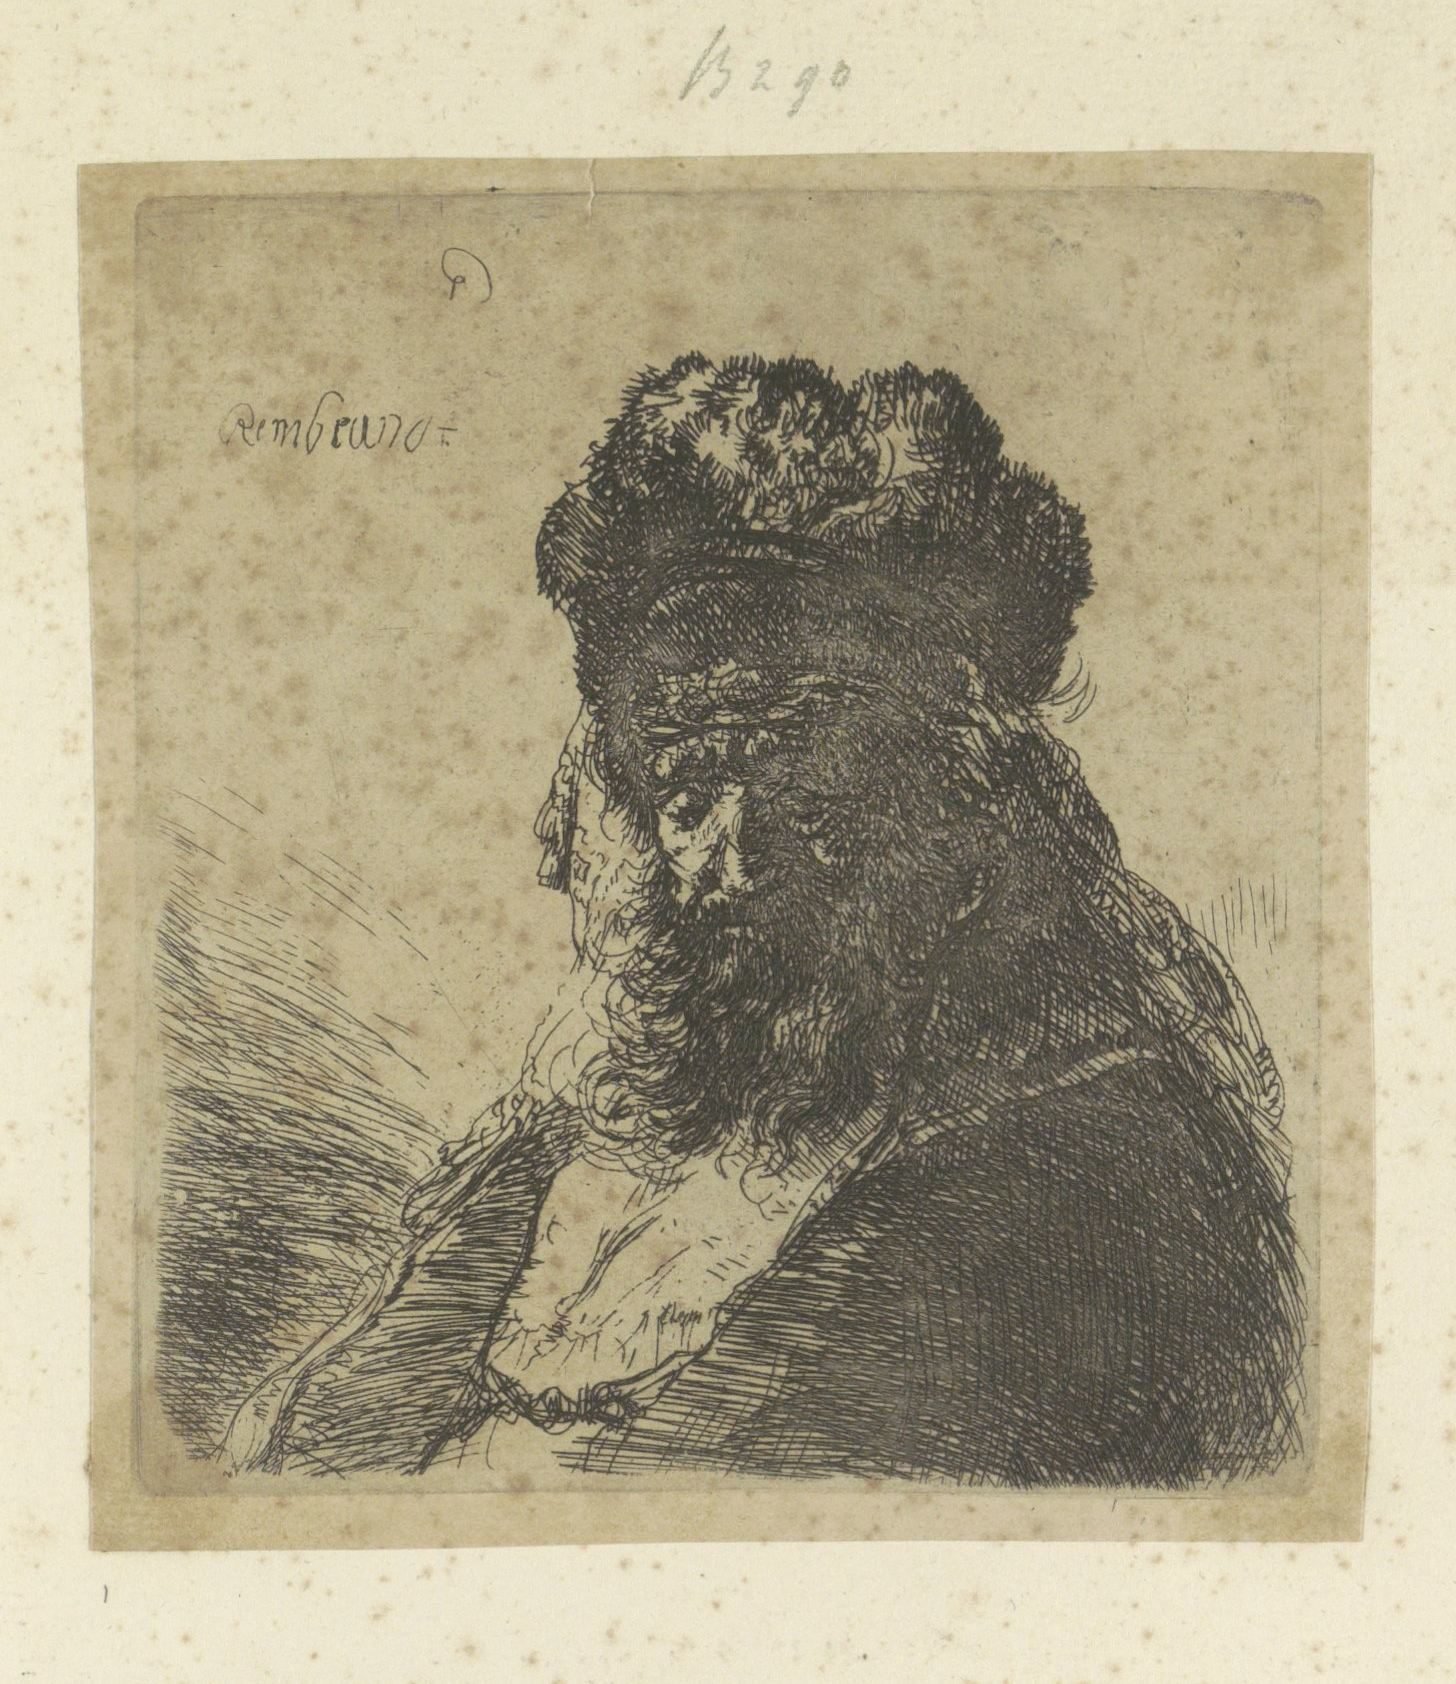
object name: print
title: Recueil de quatre-vingt-cinq estampes originales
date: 1632-1637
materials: paper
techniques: etching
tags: head-gear (with name)